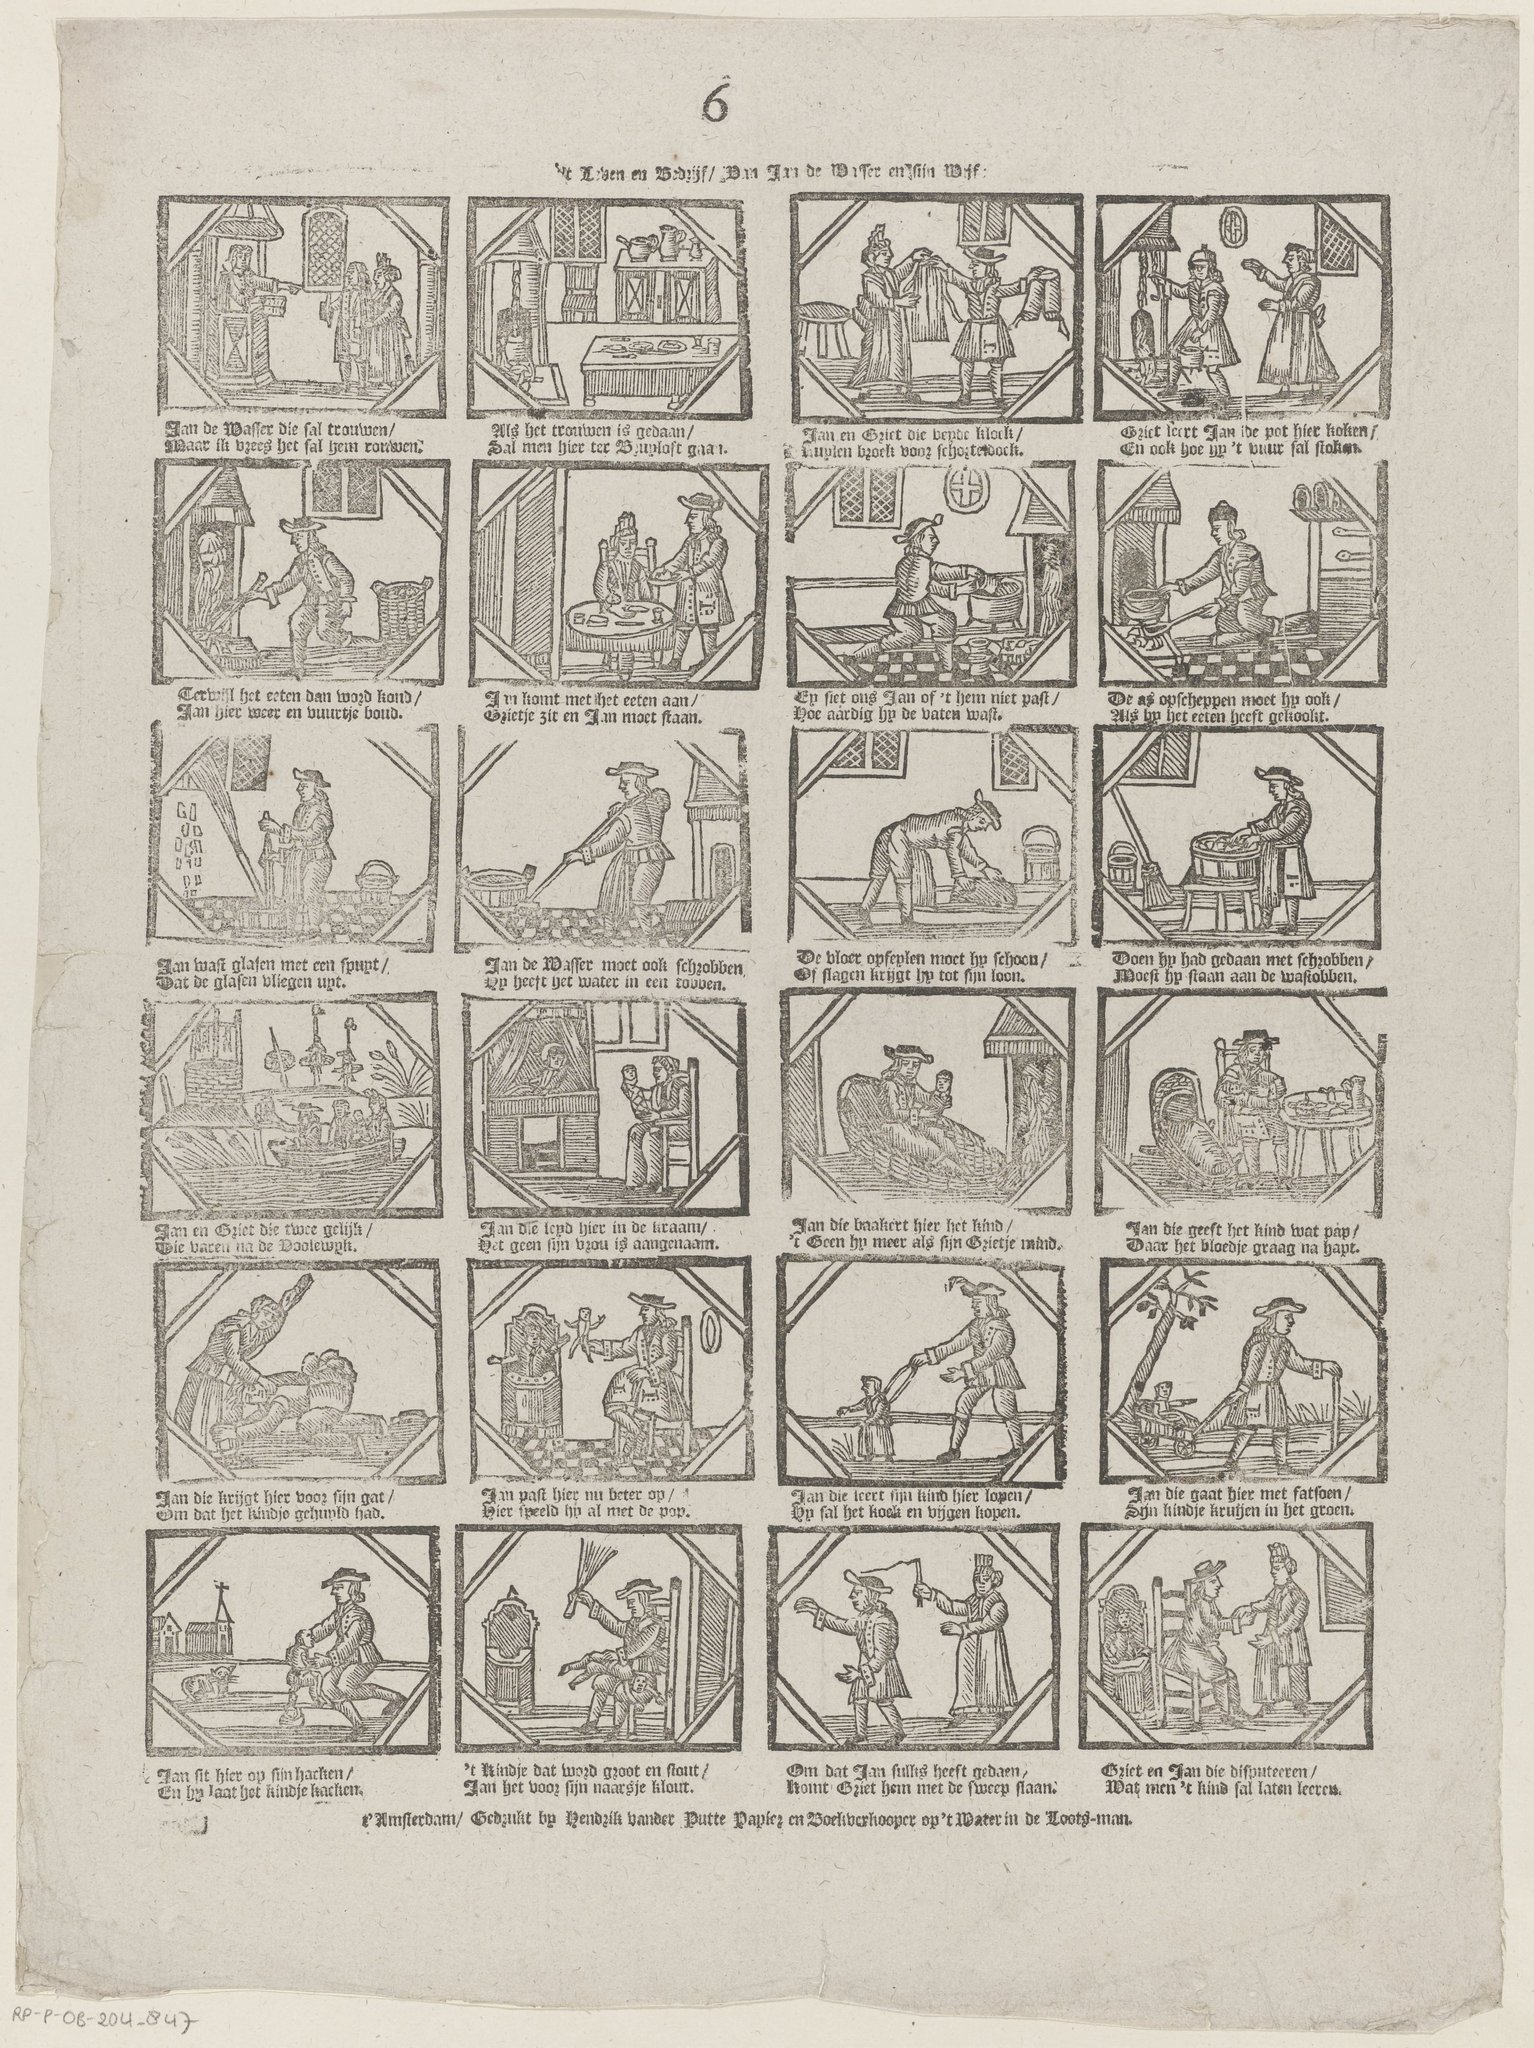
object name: print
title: 't Leven en bedrijf / Van Jan de Wasser en zijn wijf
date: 1761-1765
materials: paper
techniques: letterpress printing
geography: amsterdam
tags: hen-pecked husband, 'betty', 'molly' (man who engages in women's work)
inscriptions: collector's mark: Lugt 2760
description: Blad met 24 voorstellingen uit het leven van Jan de Wasser, een man die van zijn vrouw Griet, die de broek aan heeft, al het huishoudelijk werk moet doen. Onder elke afbeelding een tweeregelig vers. Genummerd midden boven: 6.